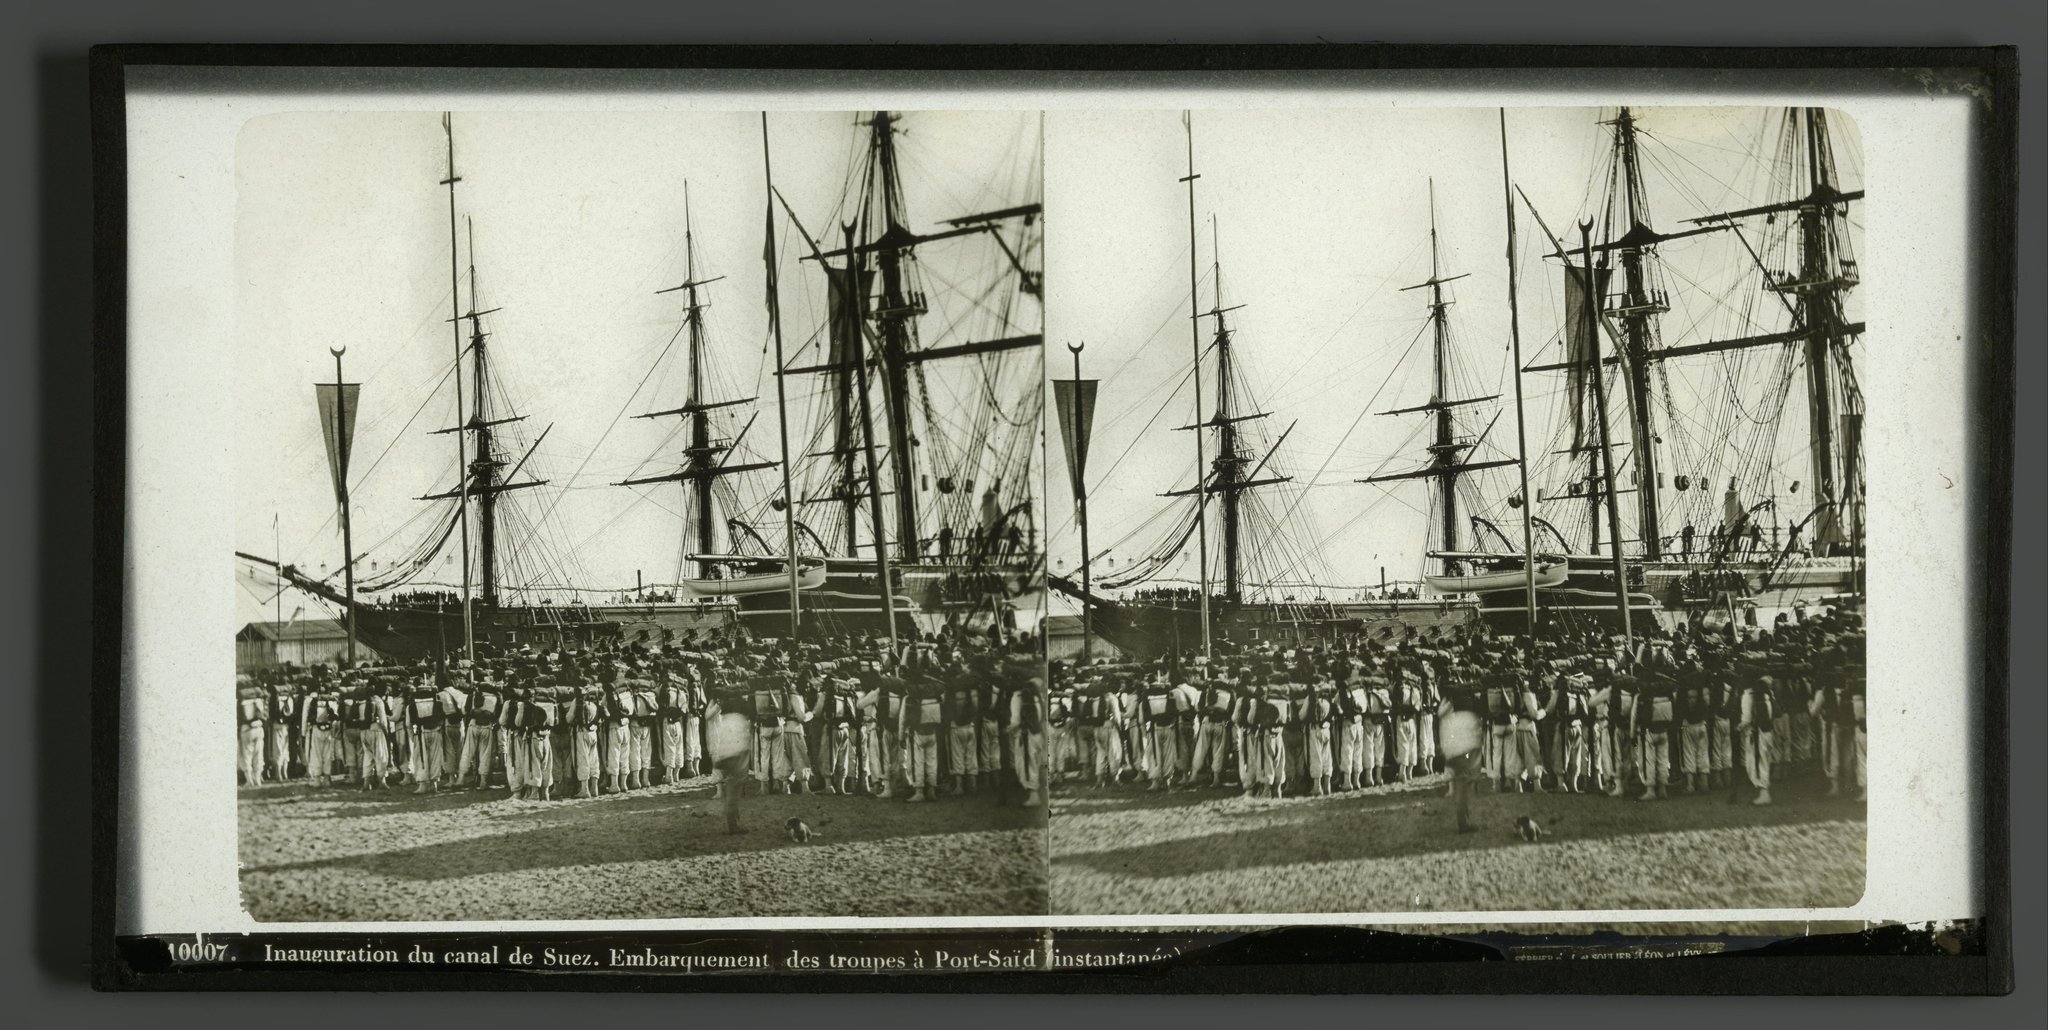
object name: stereoscopic photograph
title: Soldaten in de haven van Port Saïd voor de opening van het Suezkanaal, Egypte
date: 1869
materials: glass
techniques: slide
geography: port said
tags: harbour, troop movements, transportation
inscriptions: number: ‘10007.’